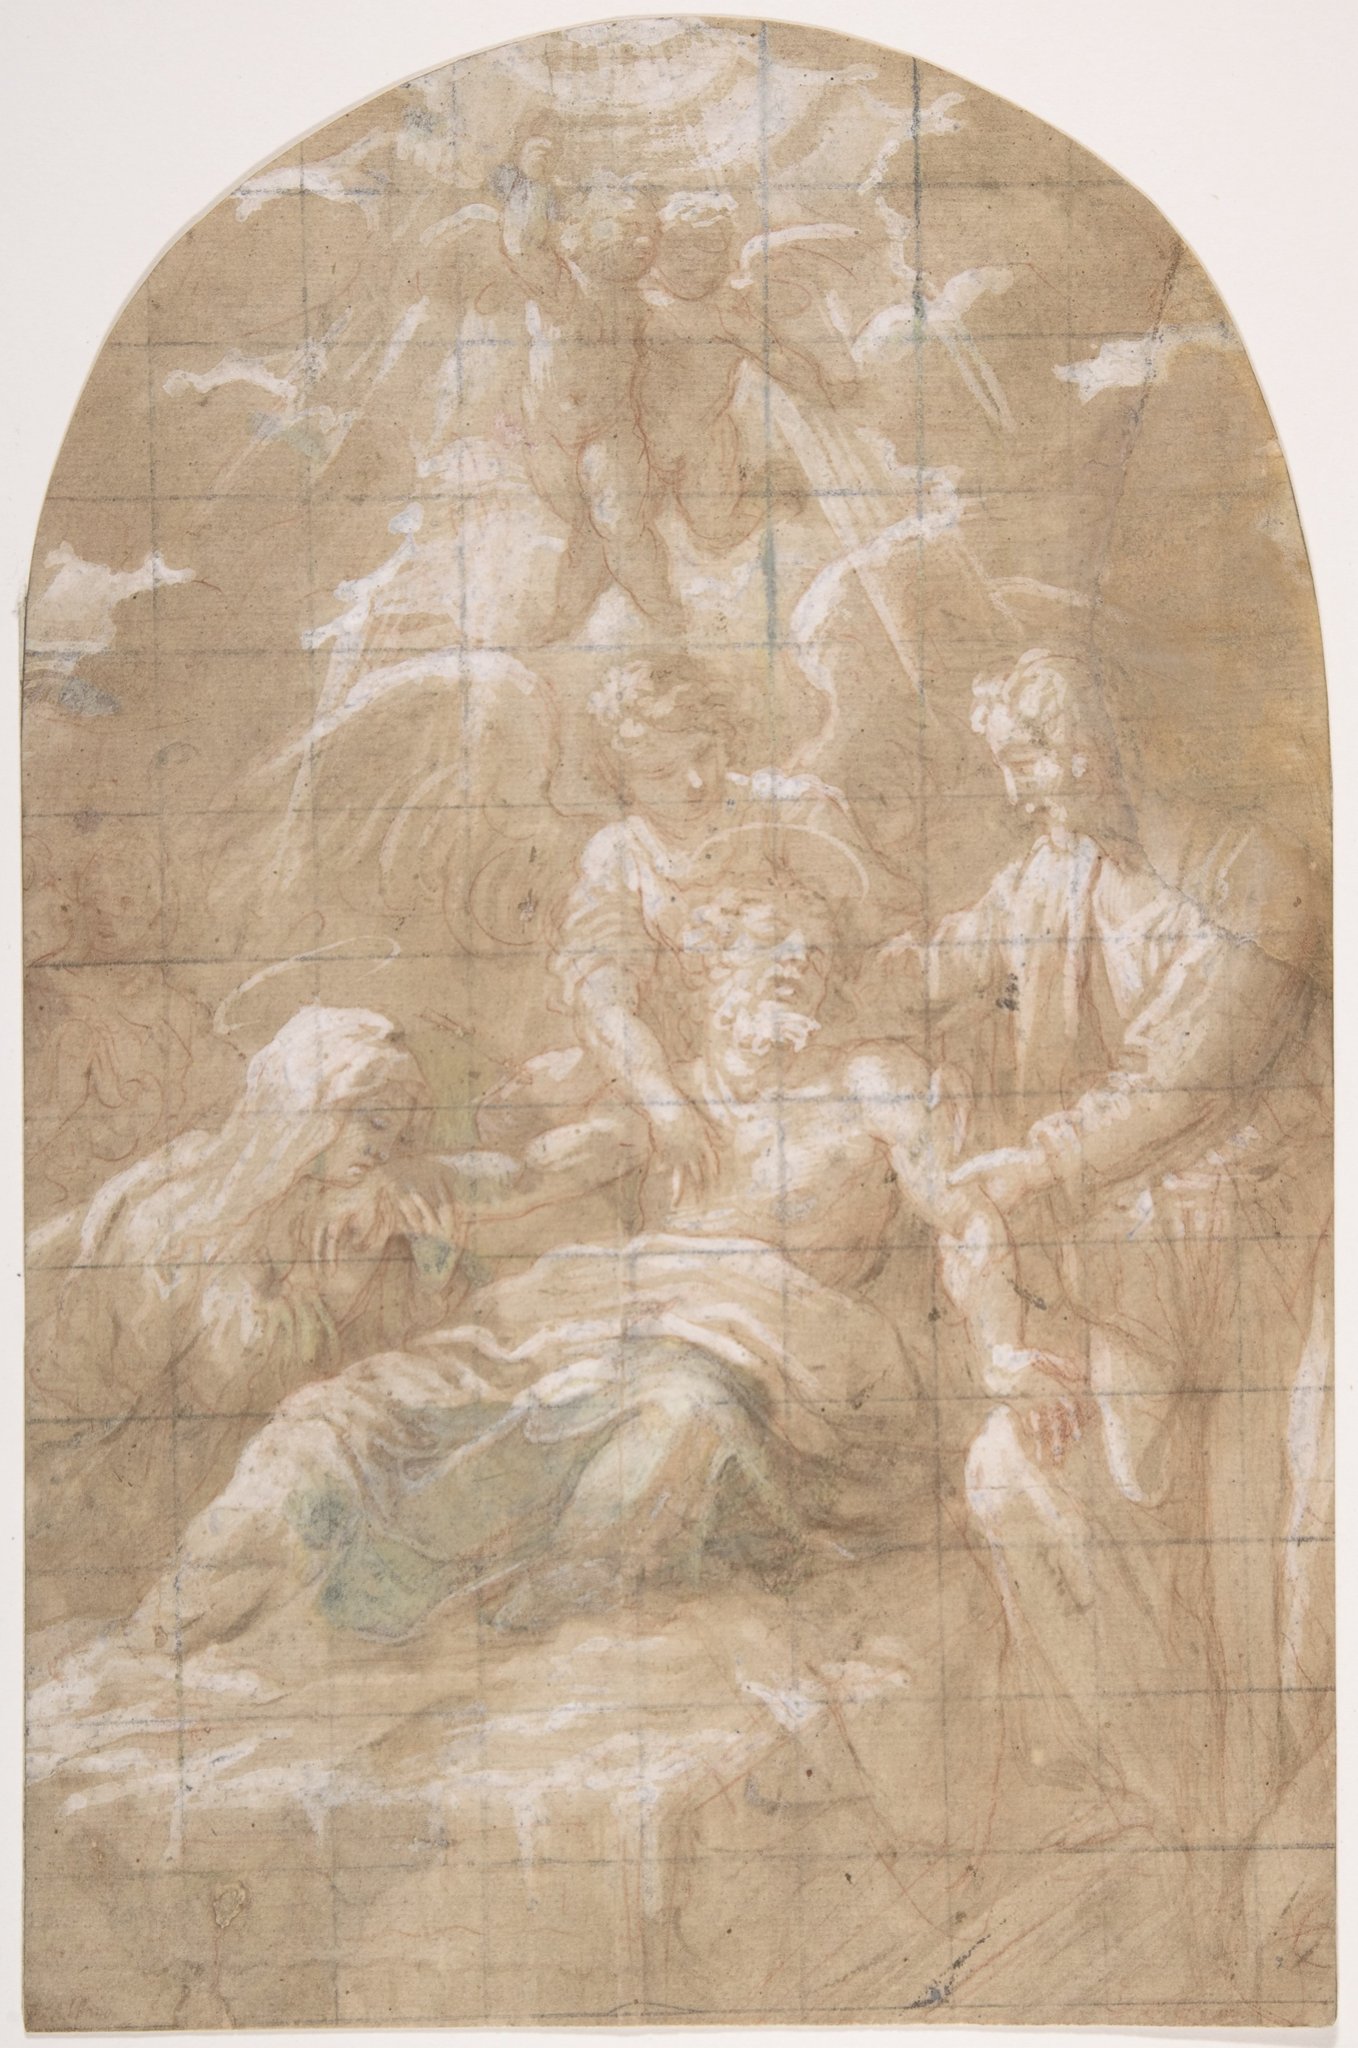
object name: drawing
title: Death of Saint Joseph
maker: anonymous, italian, emilian (parmese), 17th century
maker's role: artist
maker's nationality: italian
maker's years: 1600-1700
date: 1601-1700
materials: chalk, gouache, ink, paper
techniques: highlighting, pen, drawing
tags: angels,christ,saint joseph,virgin mary,death